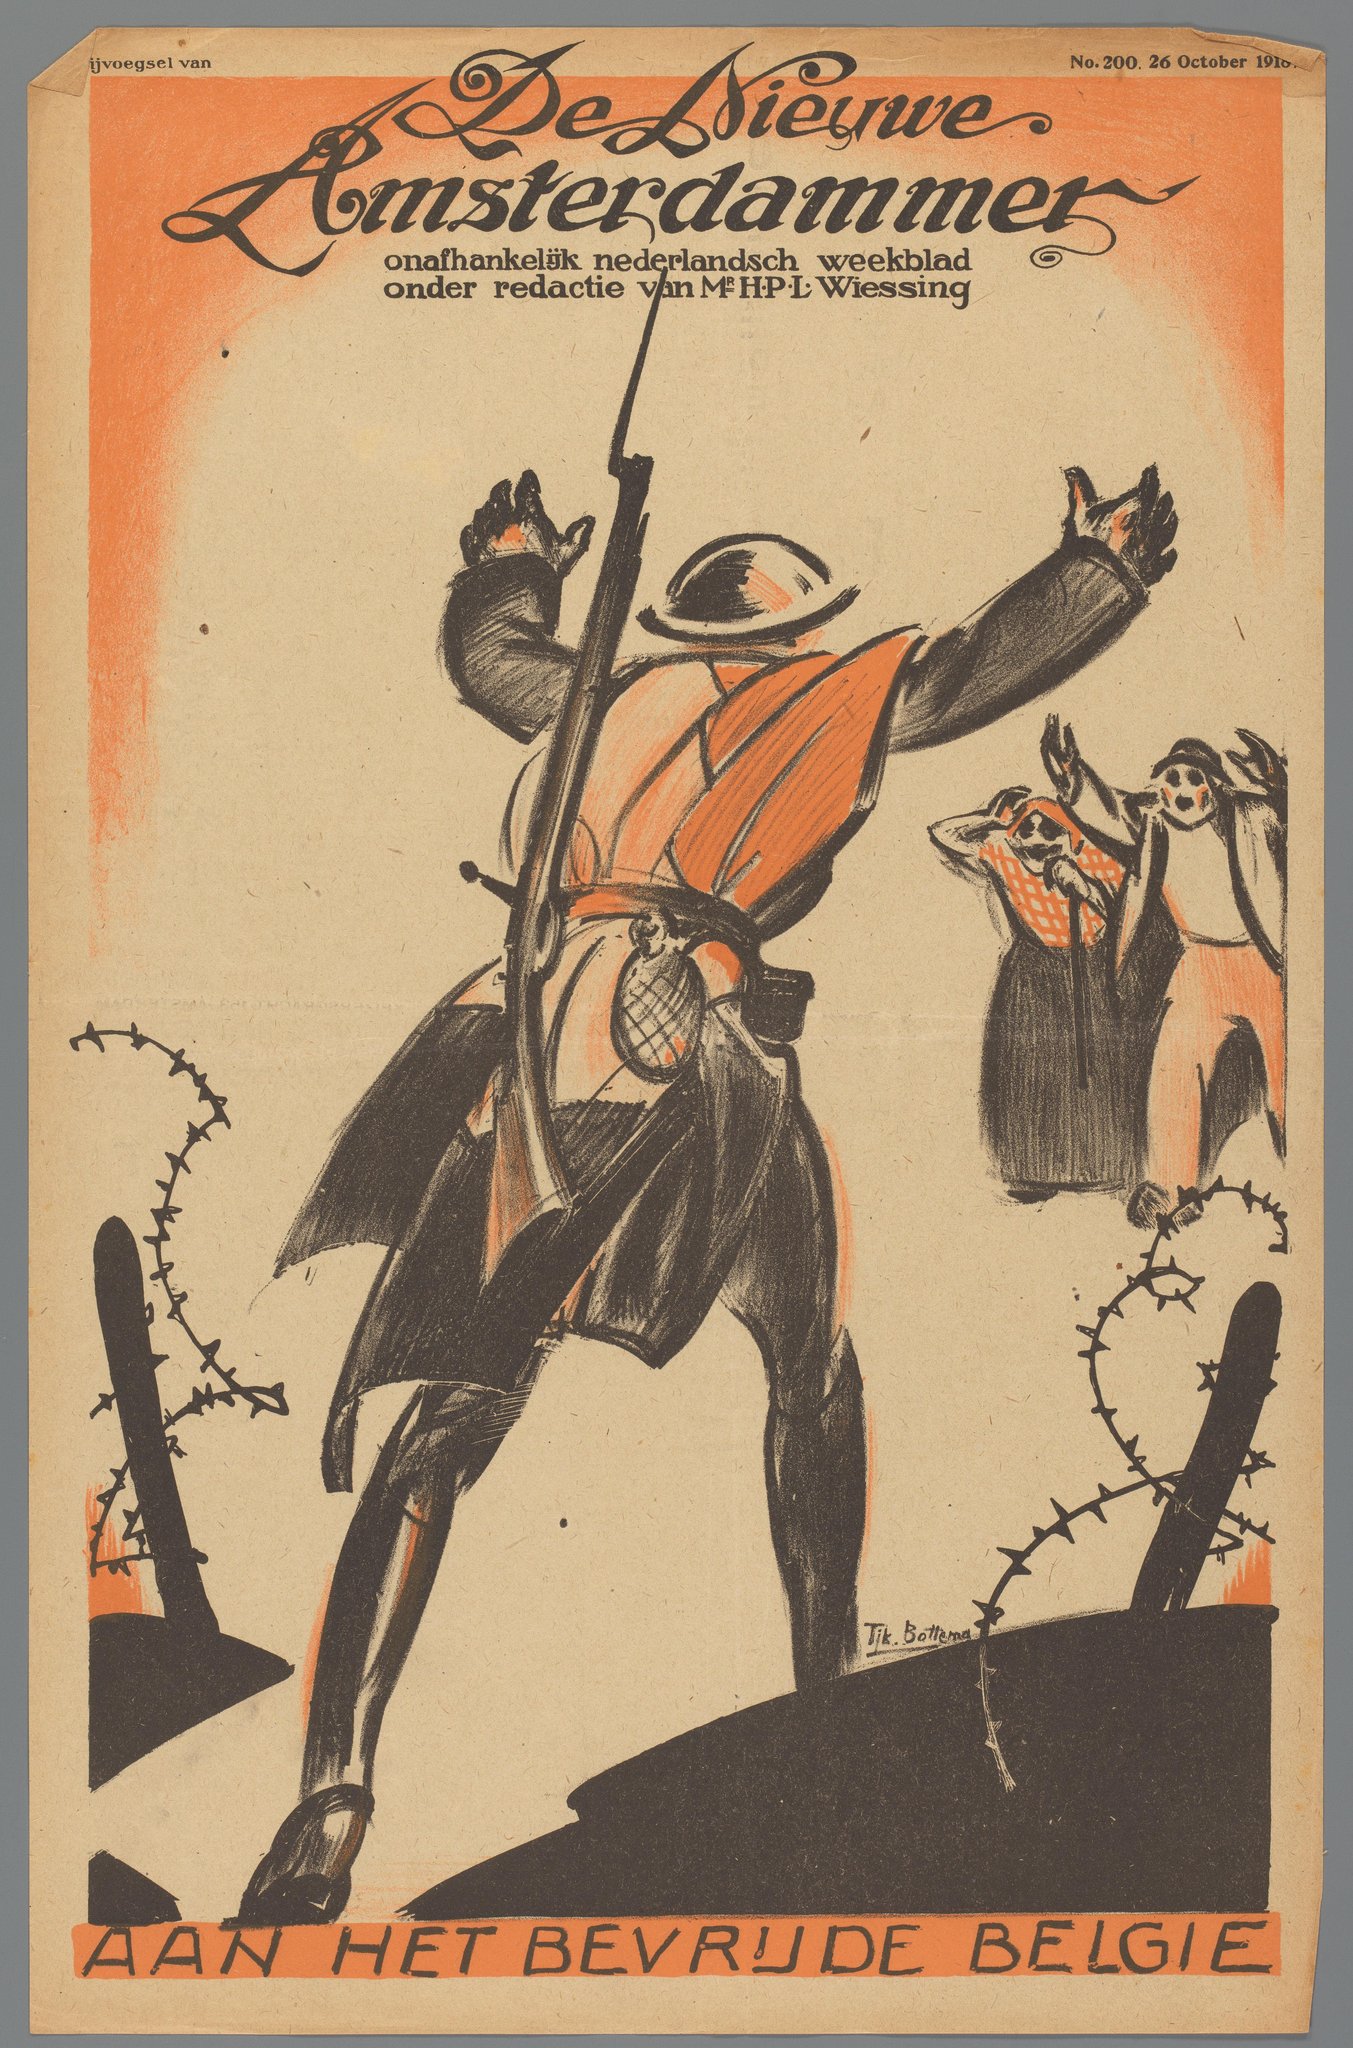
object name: print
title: Aan het bevrijde Belgie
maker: tjerk bottema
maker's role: draughtsman, print maker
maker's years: 1882-1940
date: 1918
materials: paper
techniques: lithograph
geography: netherlands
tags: parents with their children, return of the soldiers to civilian life, returning home, peace, political caricatures and satires, belgium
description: Deze prent werd uitgegeven als Bijvoegsel van De Nieuwe Amsterdammer. Onafhankelijk Nederlandsch weekblad onder redactie van Mr. H.P.L. Wiessing, Amsterdam, nr. 200, 26 oktober 1918.